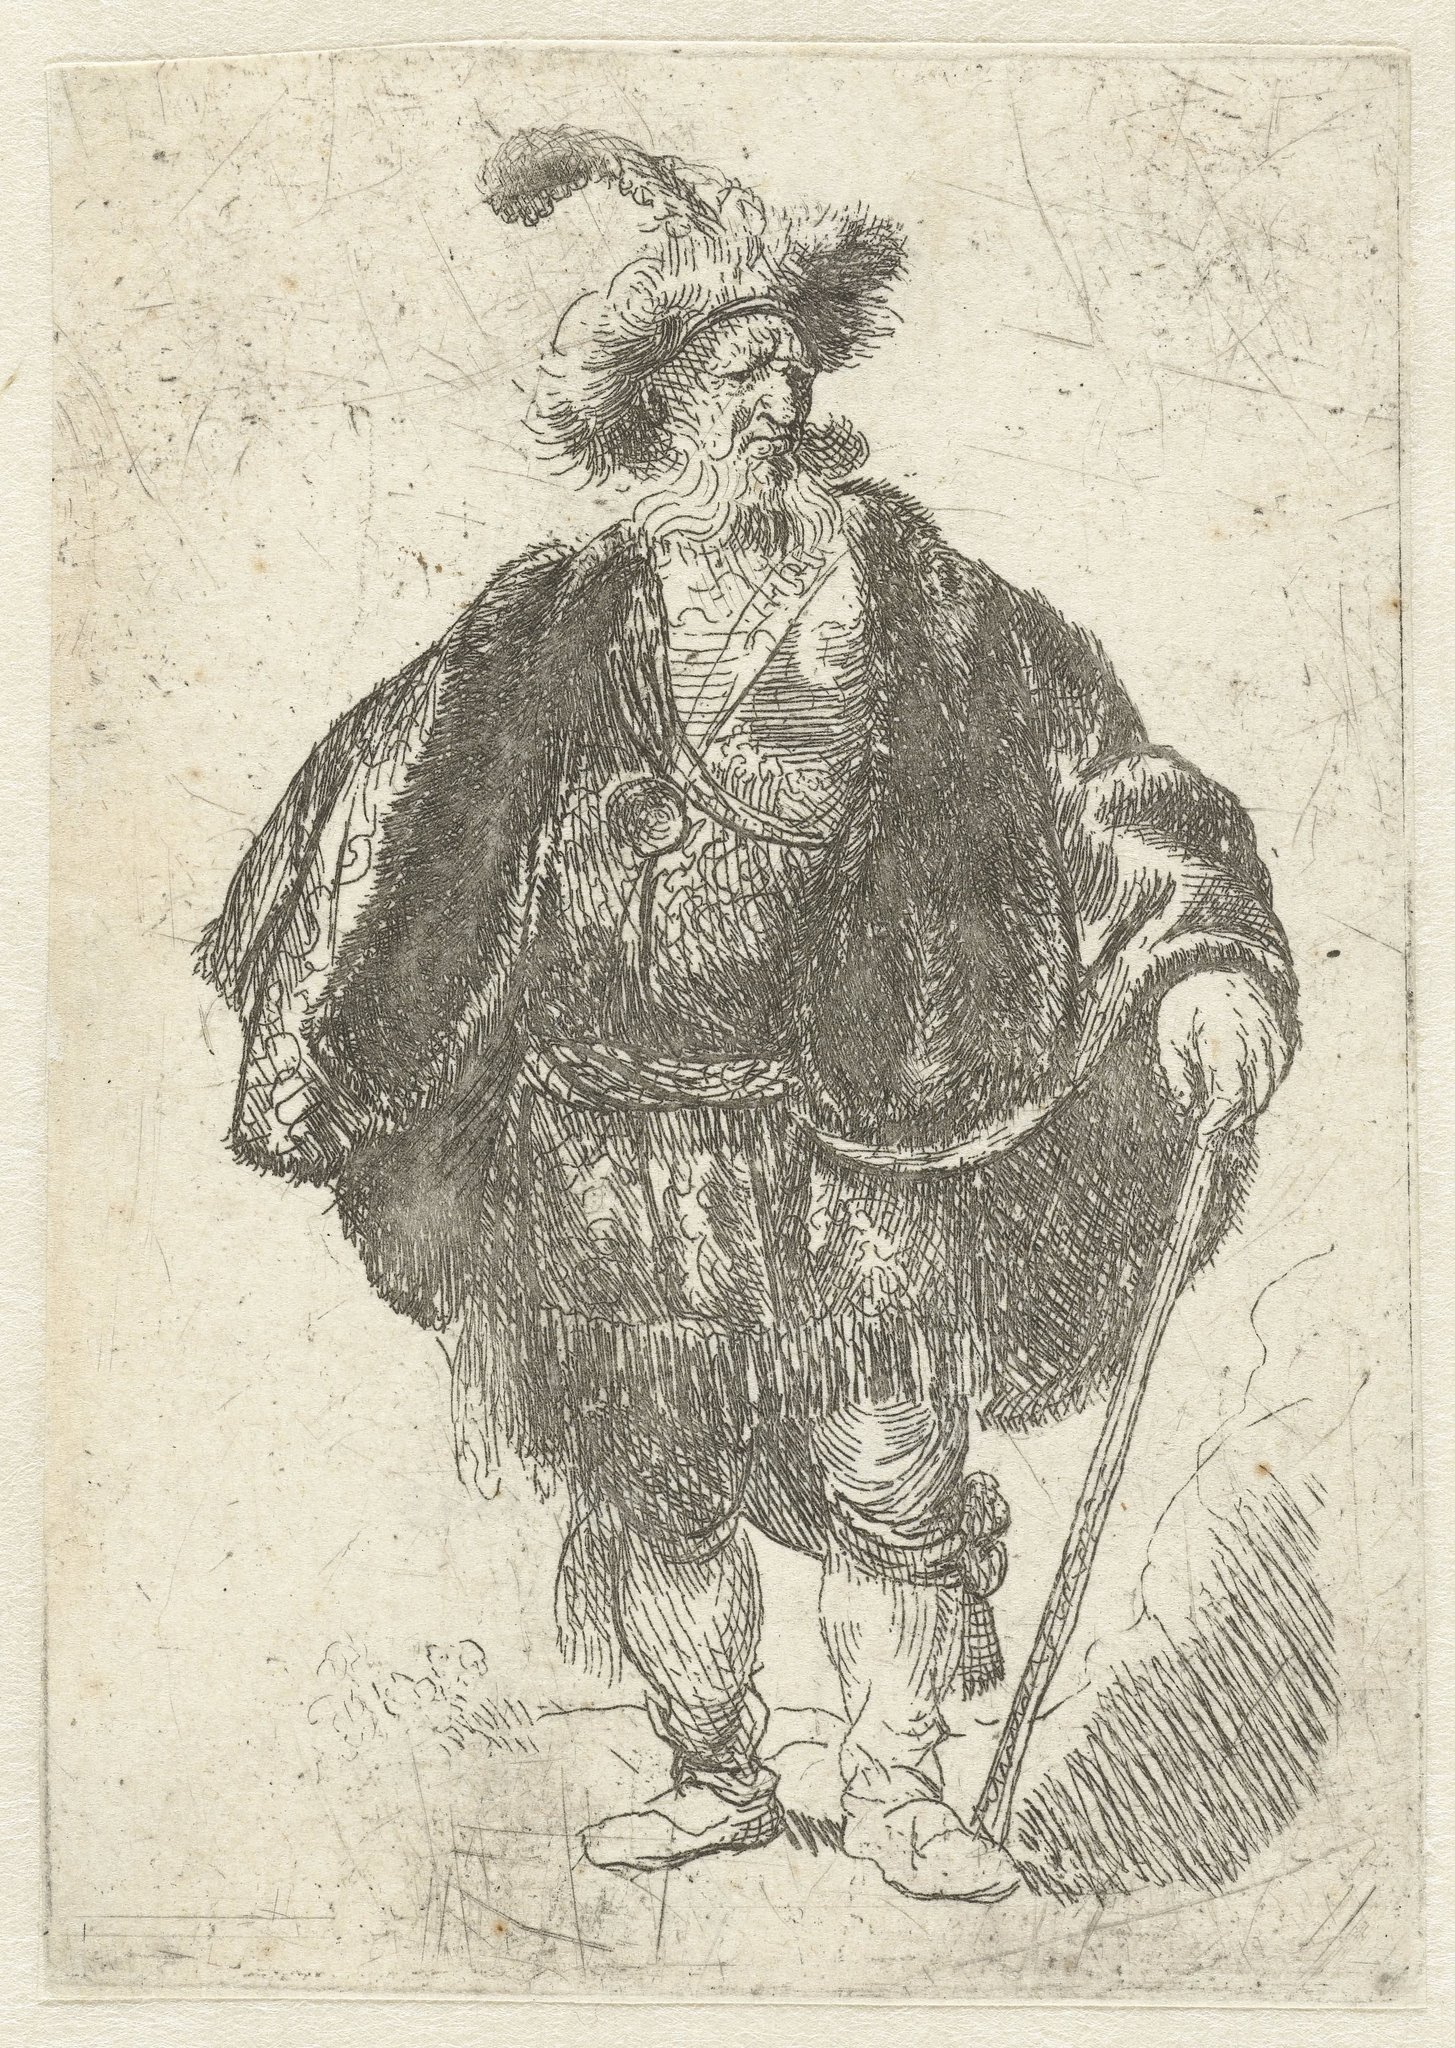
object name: print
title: The Persian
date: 1658-1693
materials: paper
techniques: etching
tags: asiatic races and peoples: persians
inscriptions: collector's mark: Lugt 240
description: Spiegelbeeldige kopie naar de gelijknamige prent van Rembrandt.